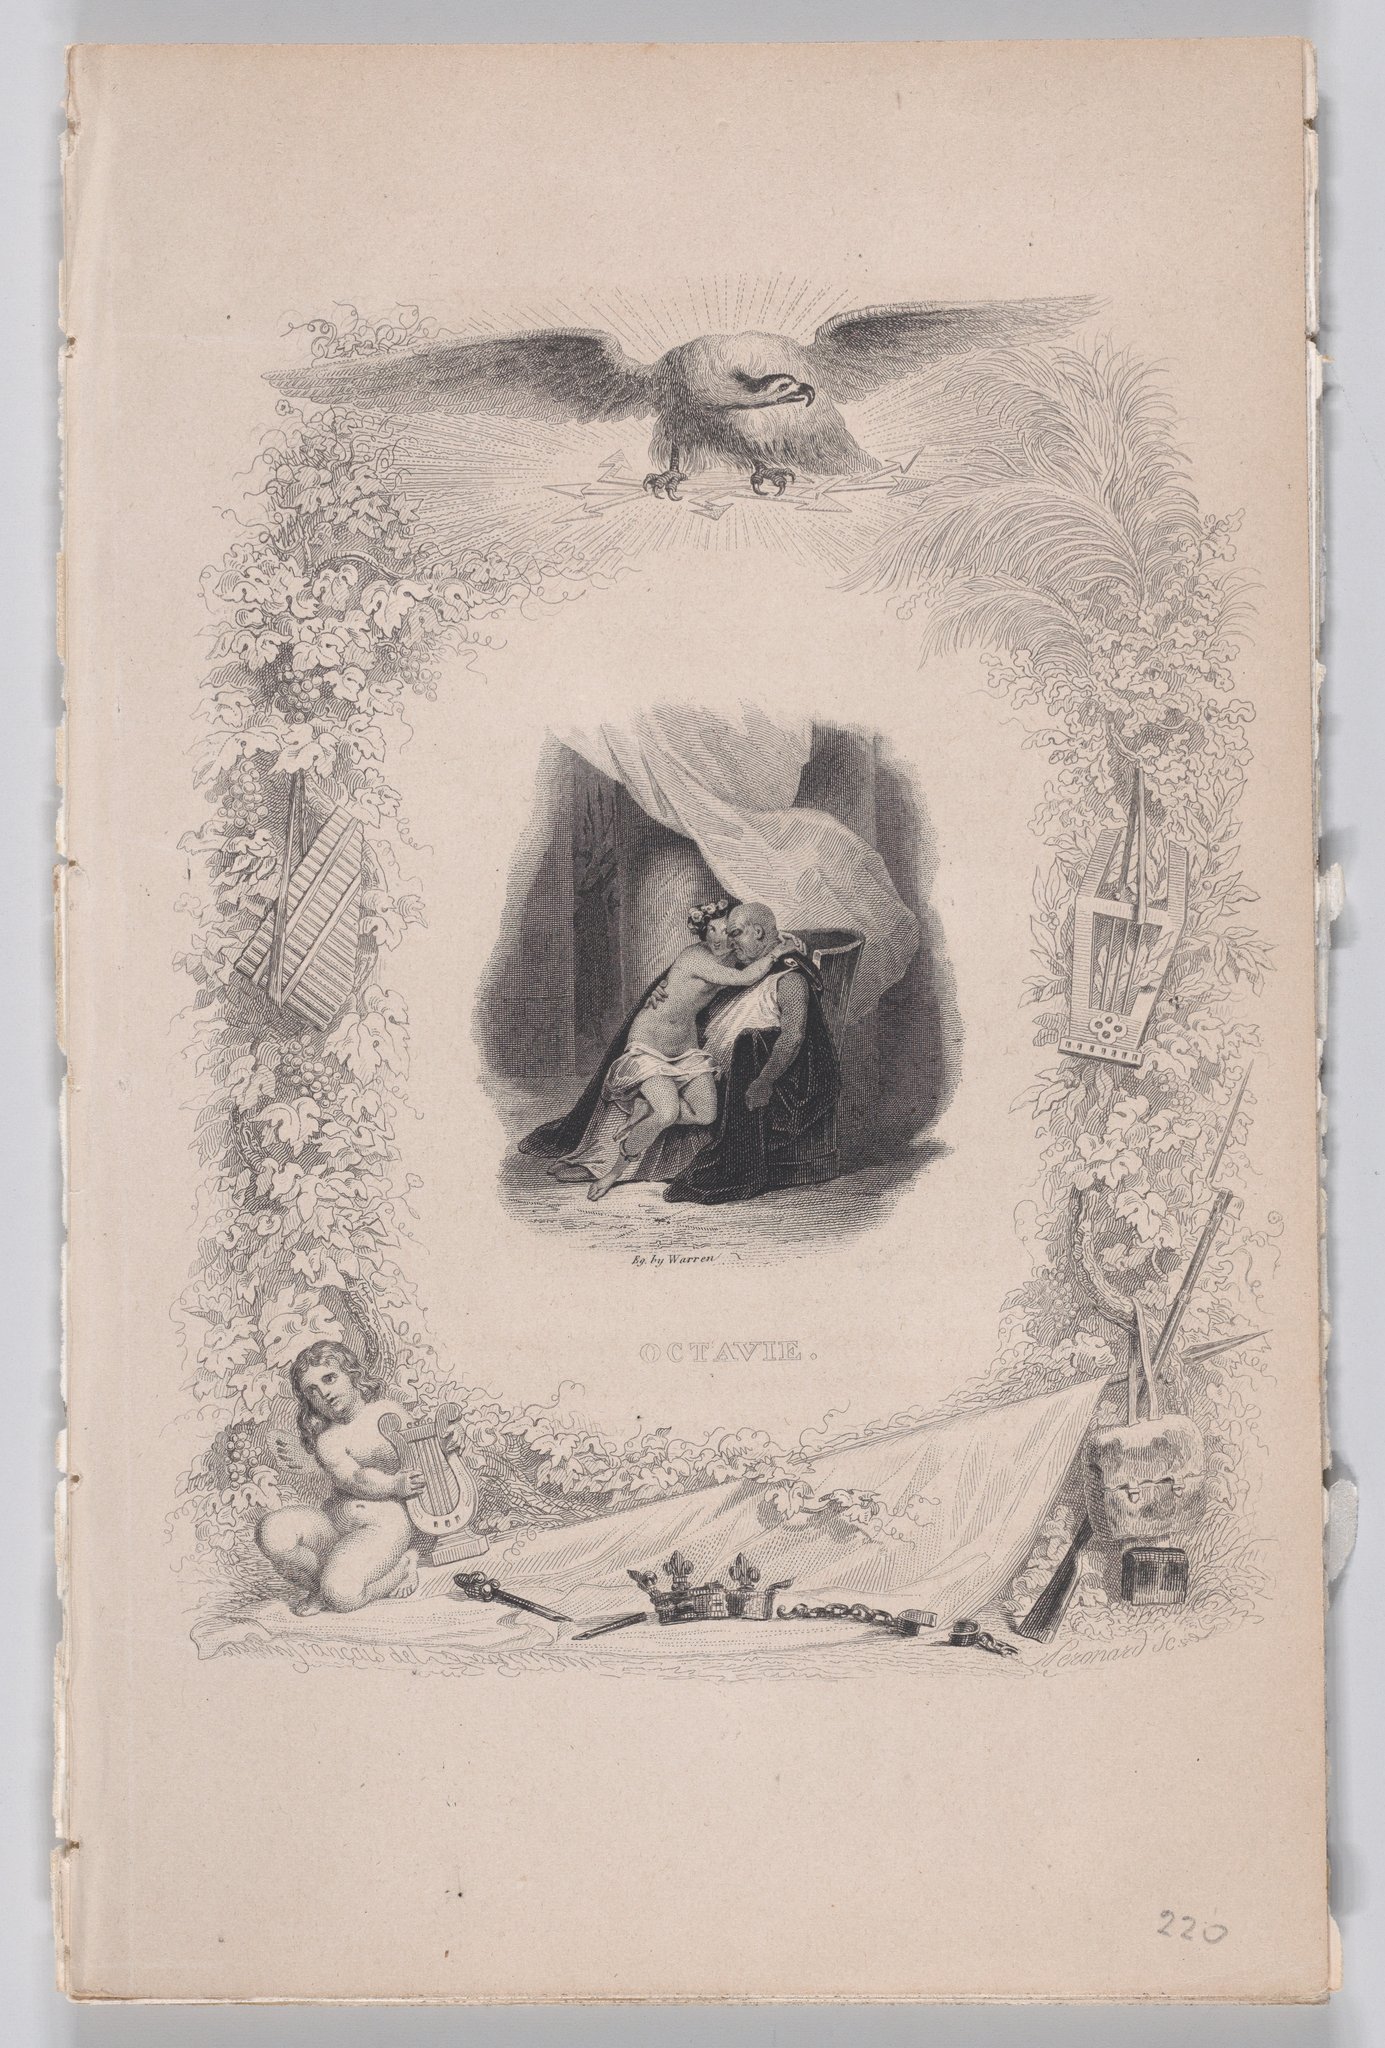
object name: print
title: Octavie, from "The Complete Works of Béranger"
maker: françois-louis français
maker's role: designer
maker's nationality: french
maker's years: 1814-1897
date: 1829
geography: paris